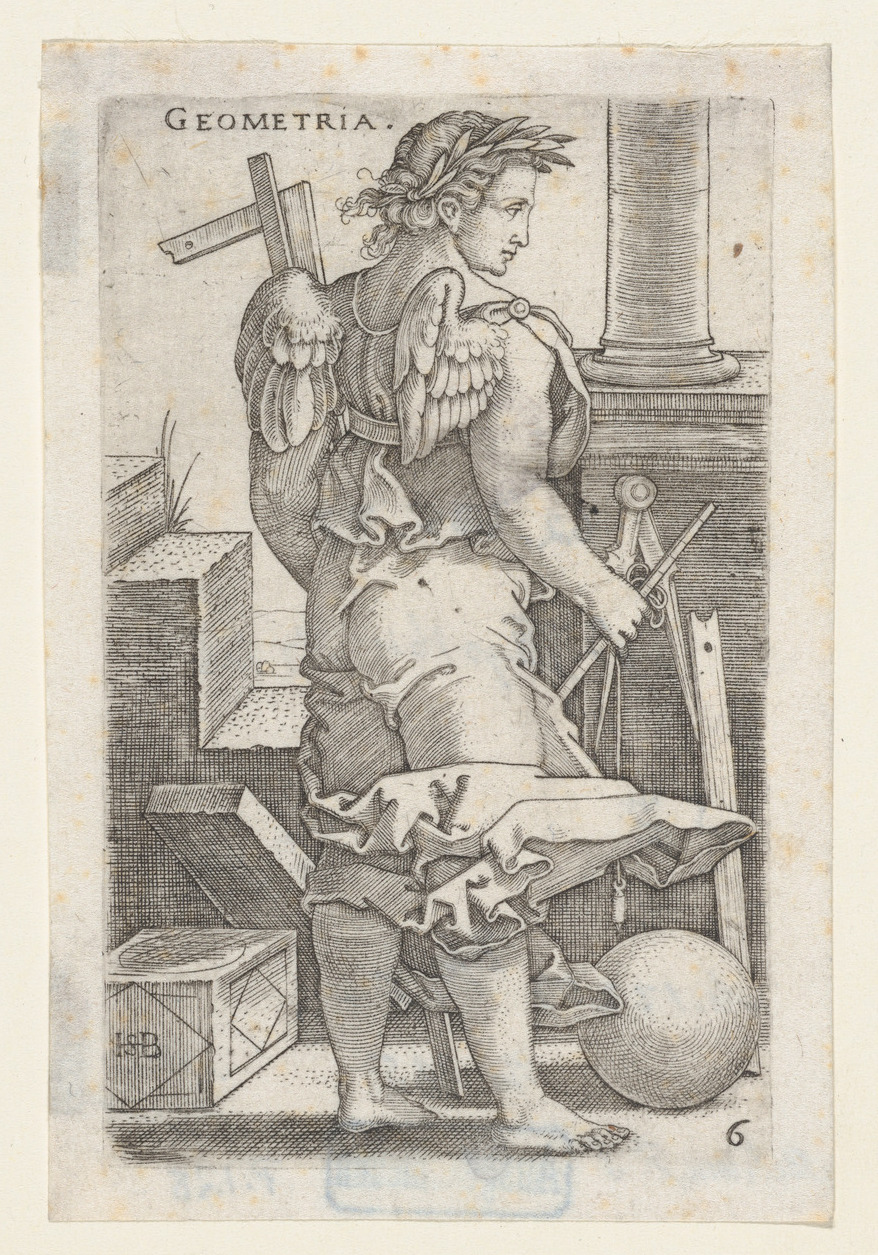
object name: print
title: Geometria, from "The Seven Liberal Arts"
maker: sebald beham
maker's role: artist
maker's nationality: german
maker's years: 1500-1550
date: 1500-1550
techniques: engraving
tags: geometry